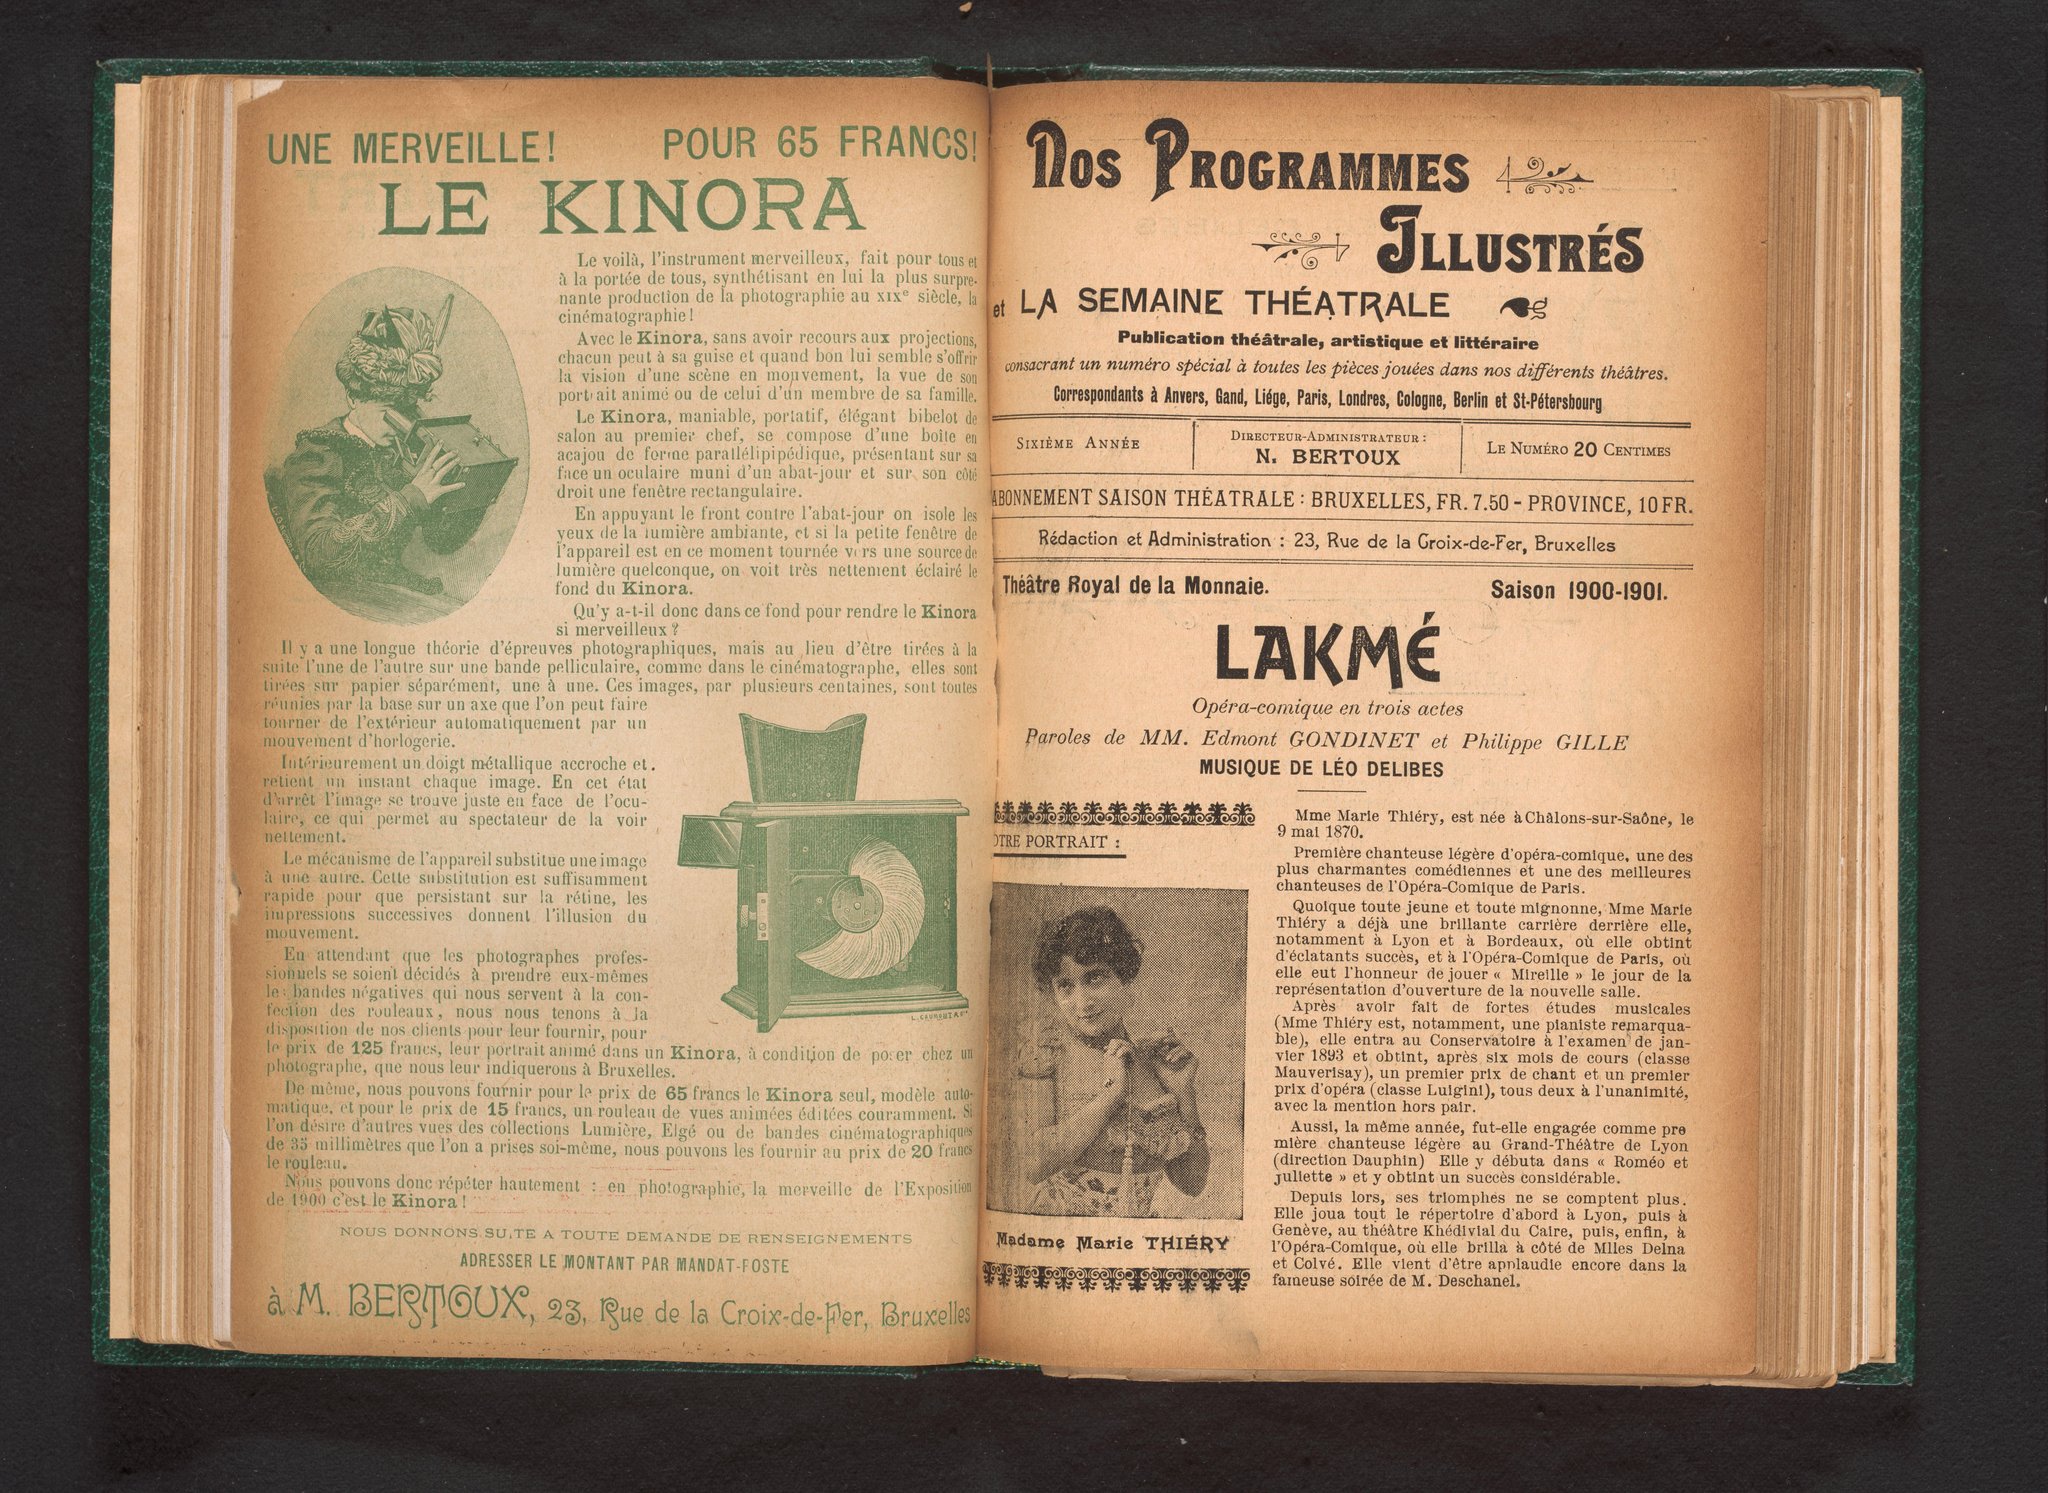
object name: page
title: Portret van Marie Thiery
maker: Anonymous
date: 1895-1900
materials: paper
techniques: autotype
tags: adult woman, historical persons